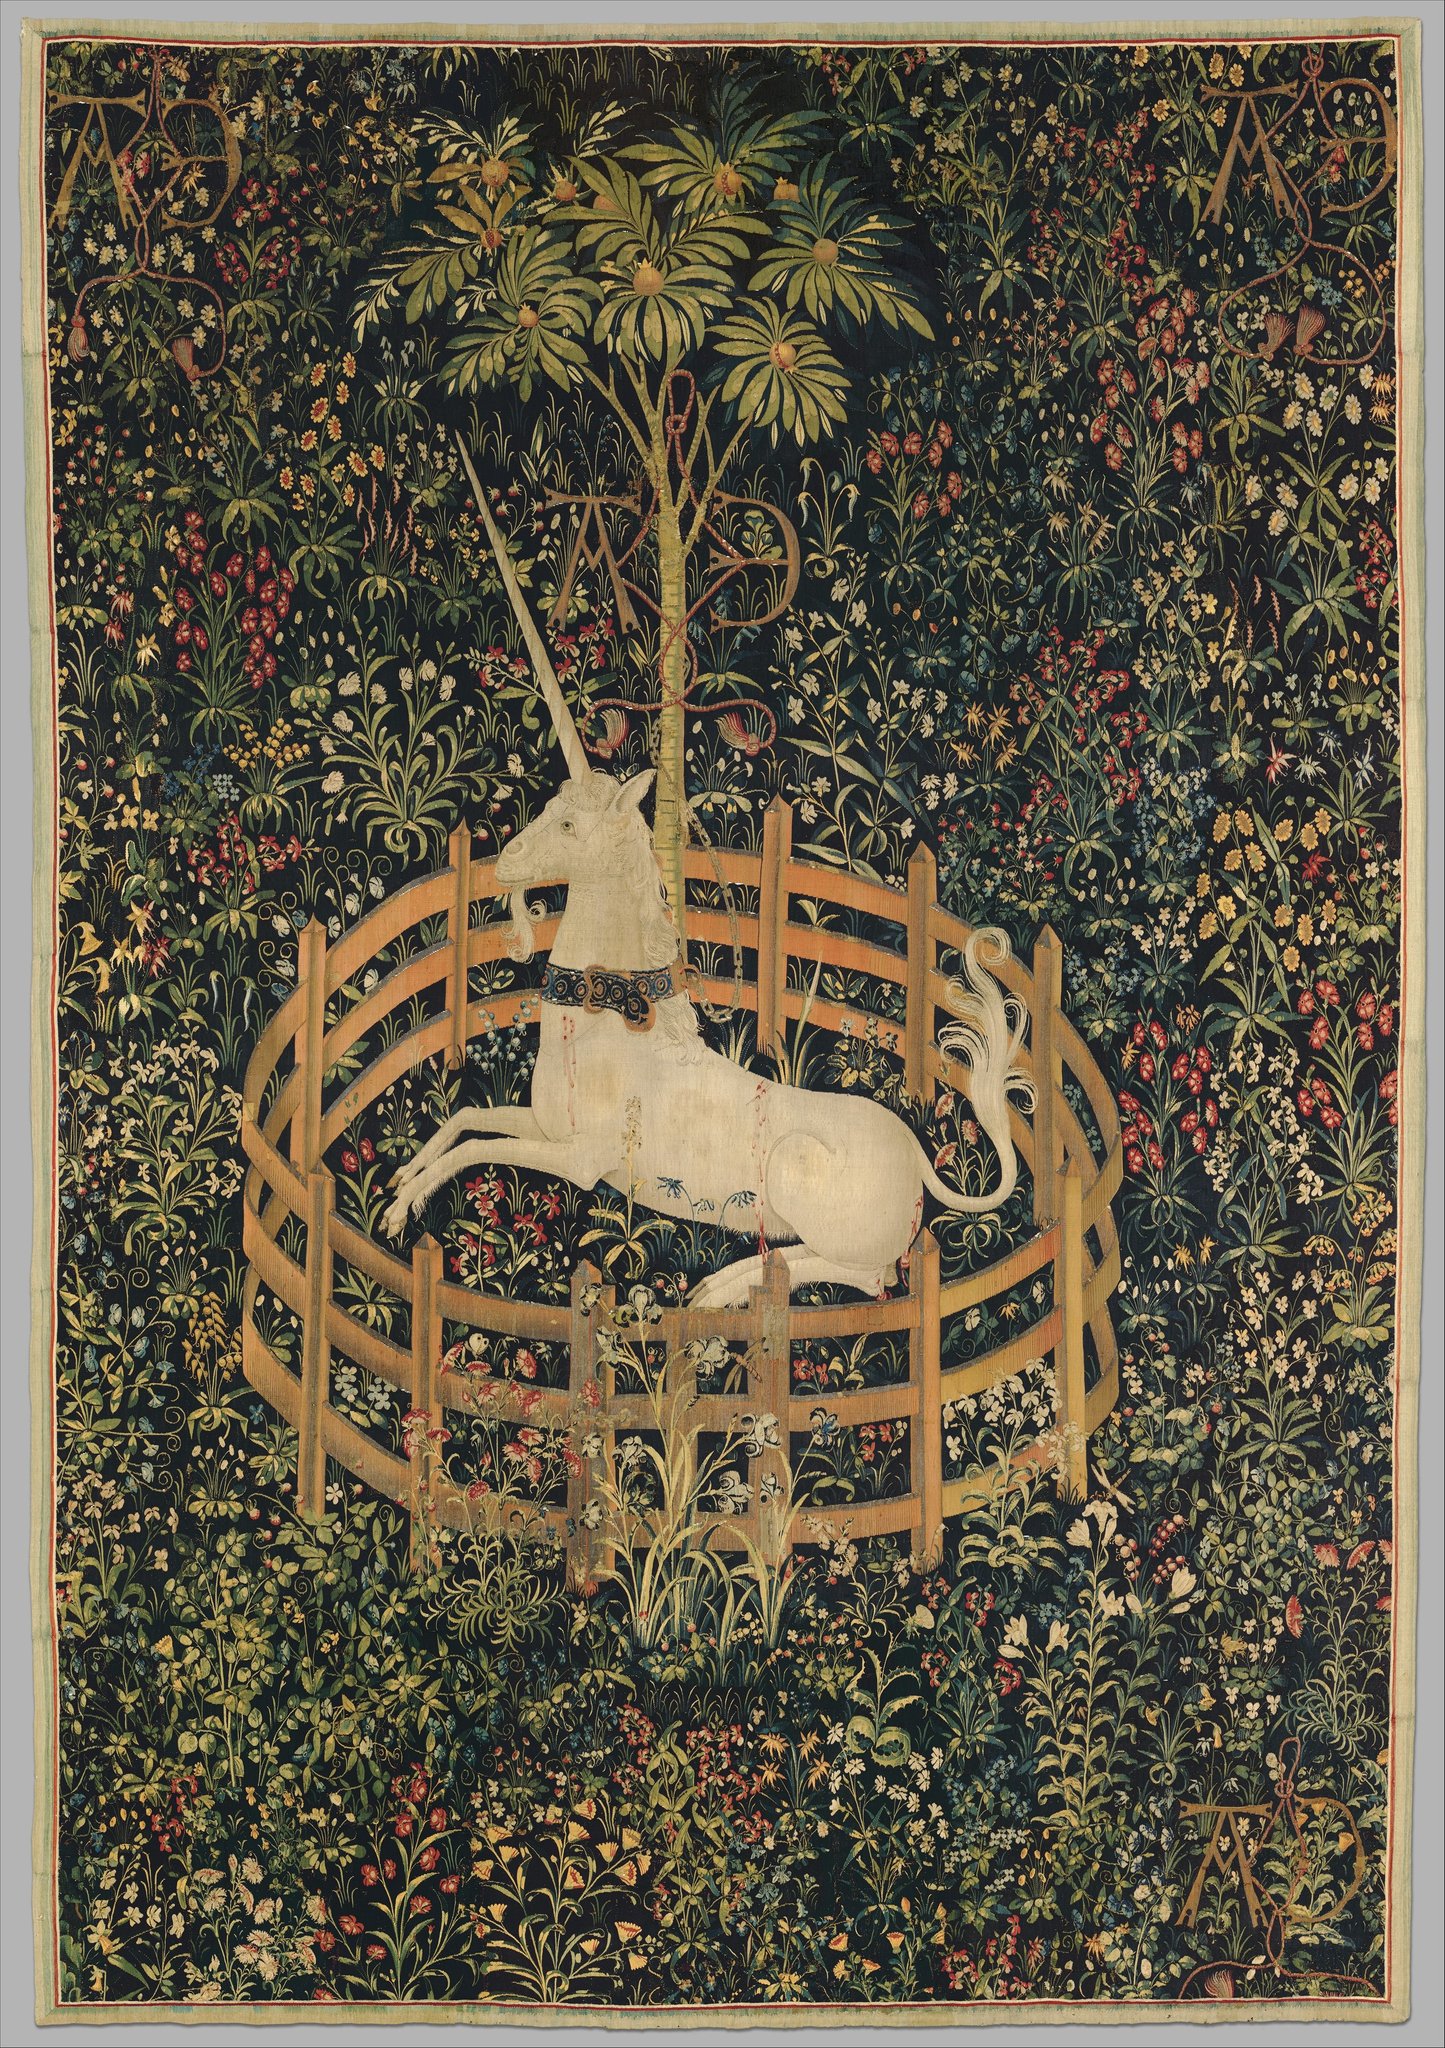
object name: tapestry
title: The Unicorn Rests in a Garden (from the Unicorn Tapestries)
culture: french or south netherlandish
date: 1495-1505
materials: gilt, silk, silver, wool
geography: netherlands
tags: unicorns,flowers,plants,trees